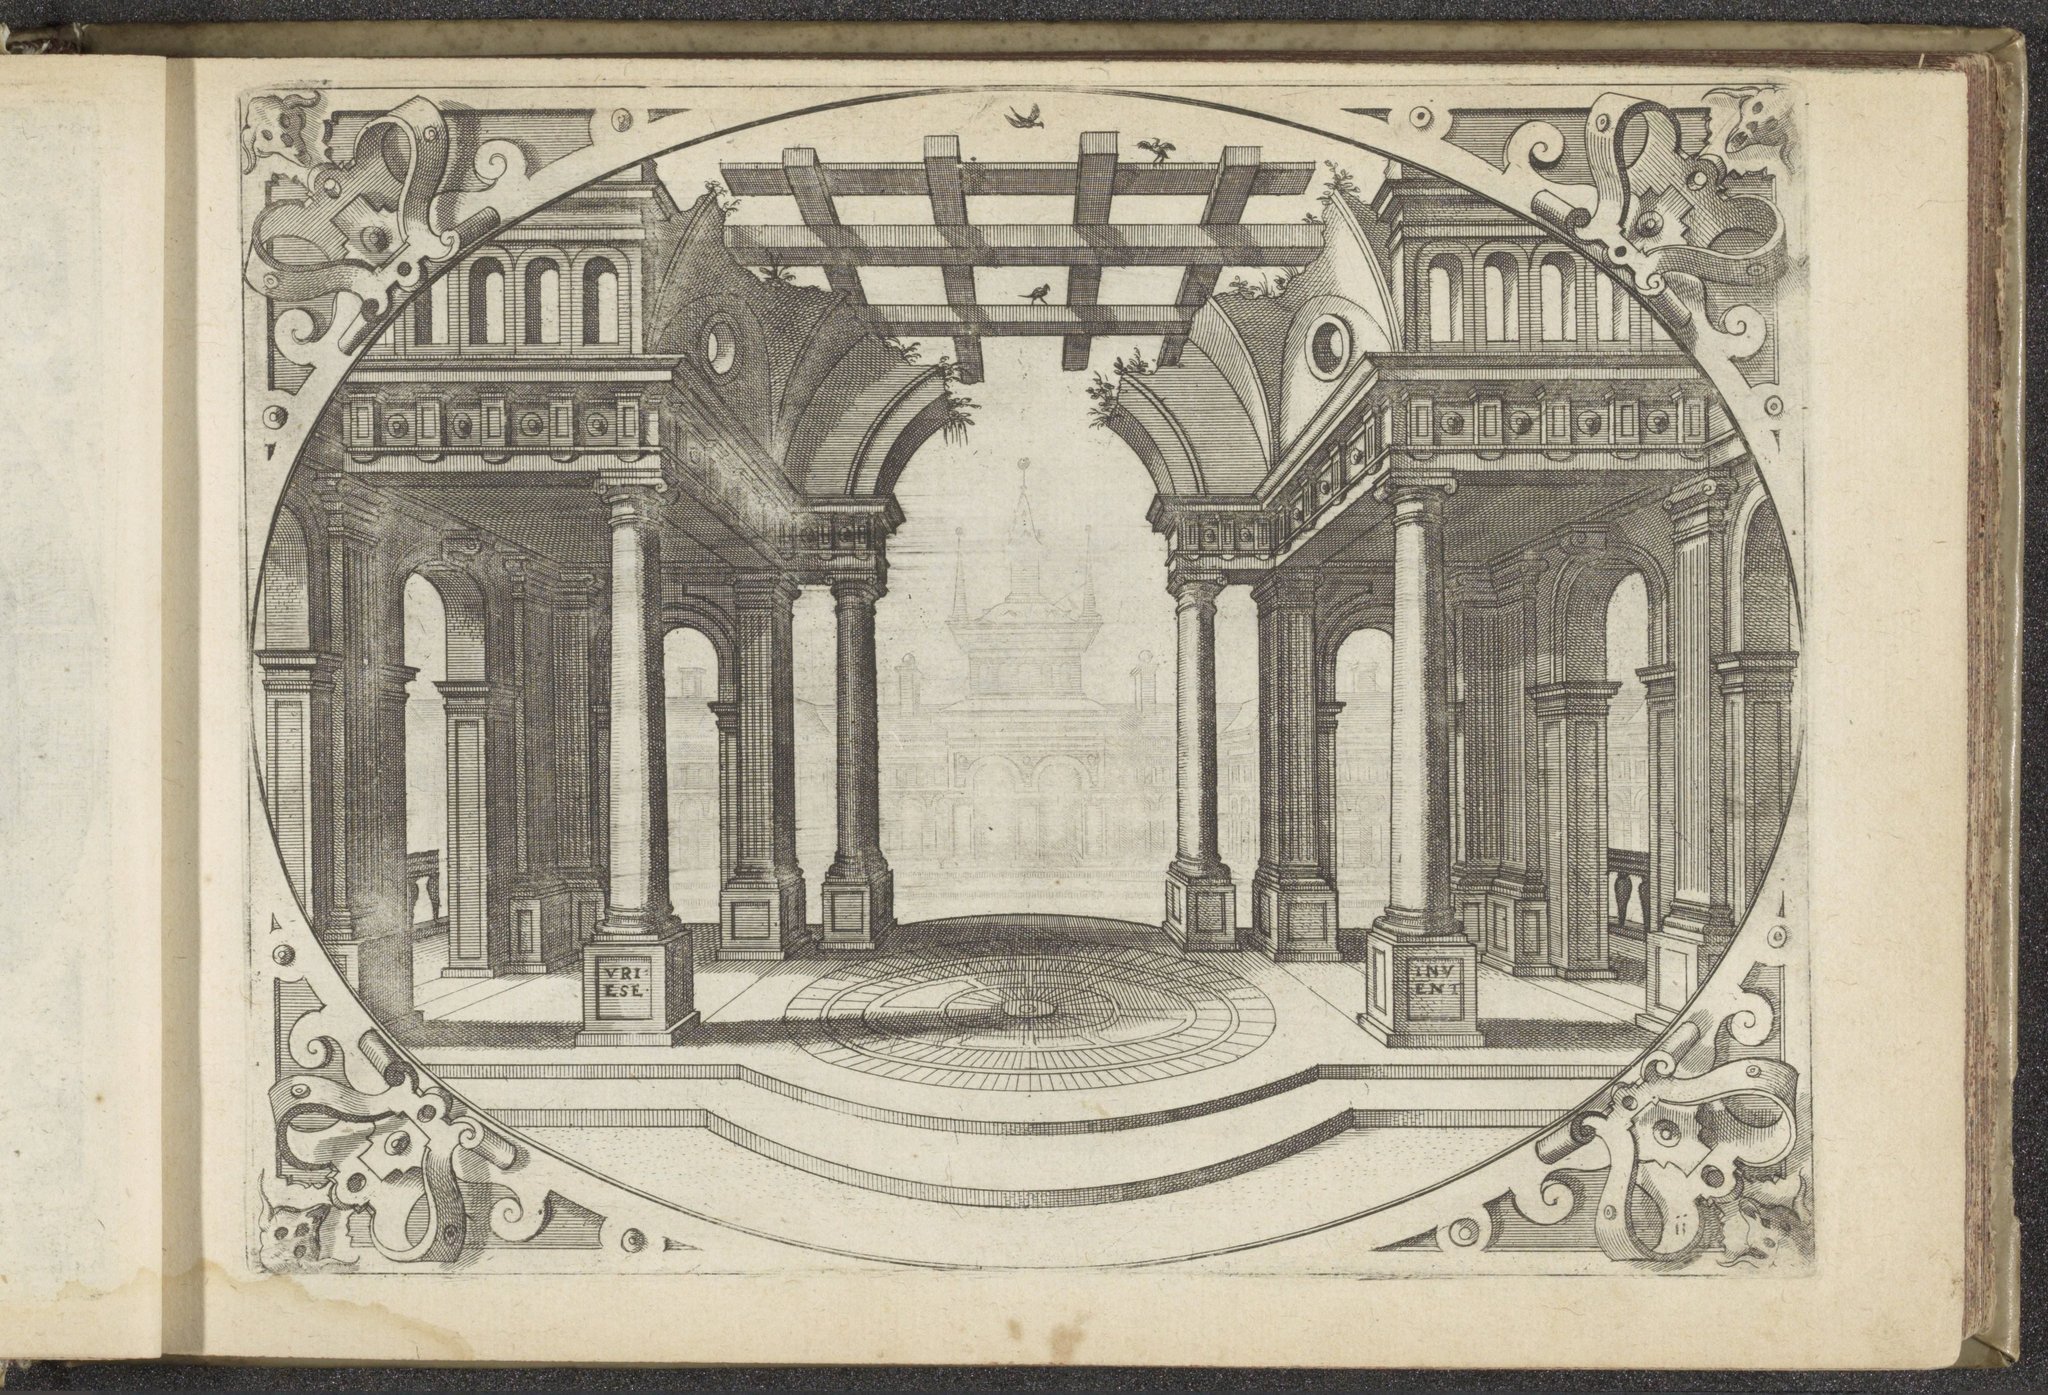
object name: album leaf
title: Variae Architecturae formae (...)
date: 1560-1562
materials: paper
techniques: etching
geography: antwerp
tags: architectural representations in general, ruin of a building ~ architecture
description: Geruïneerde poort ondersteund door Ionische zuilen. Op de achtergrond een plein en gebouwen. In de hoeken rolwerk. Deze prent maakt deel uit van een album.